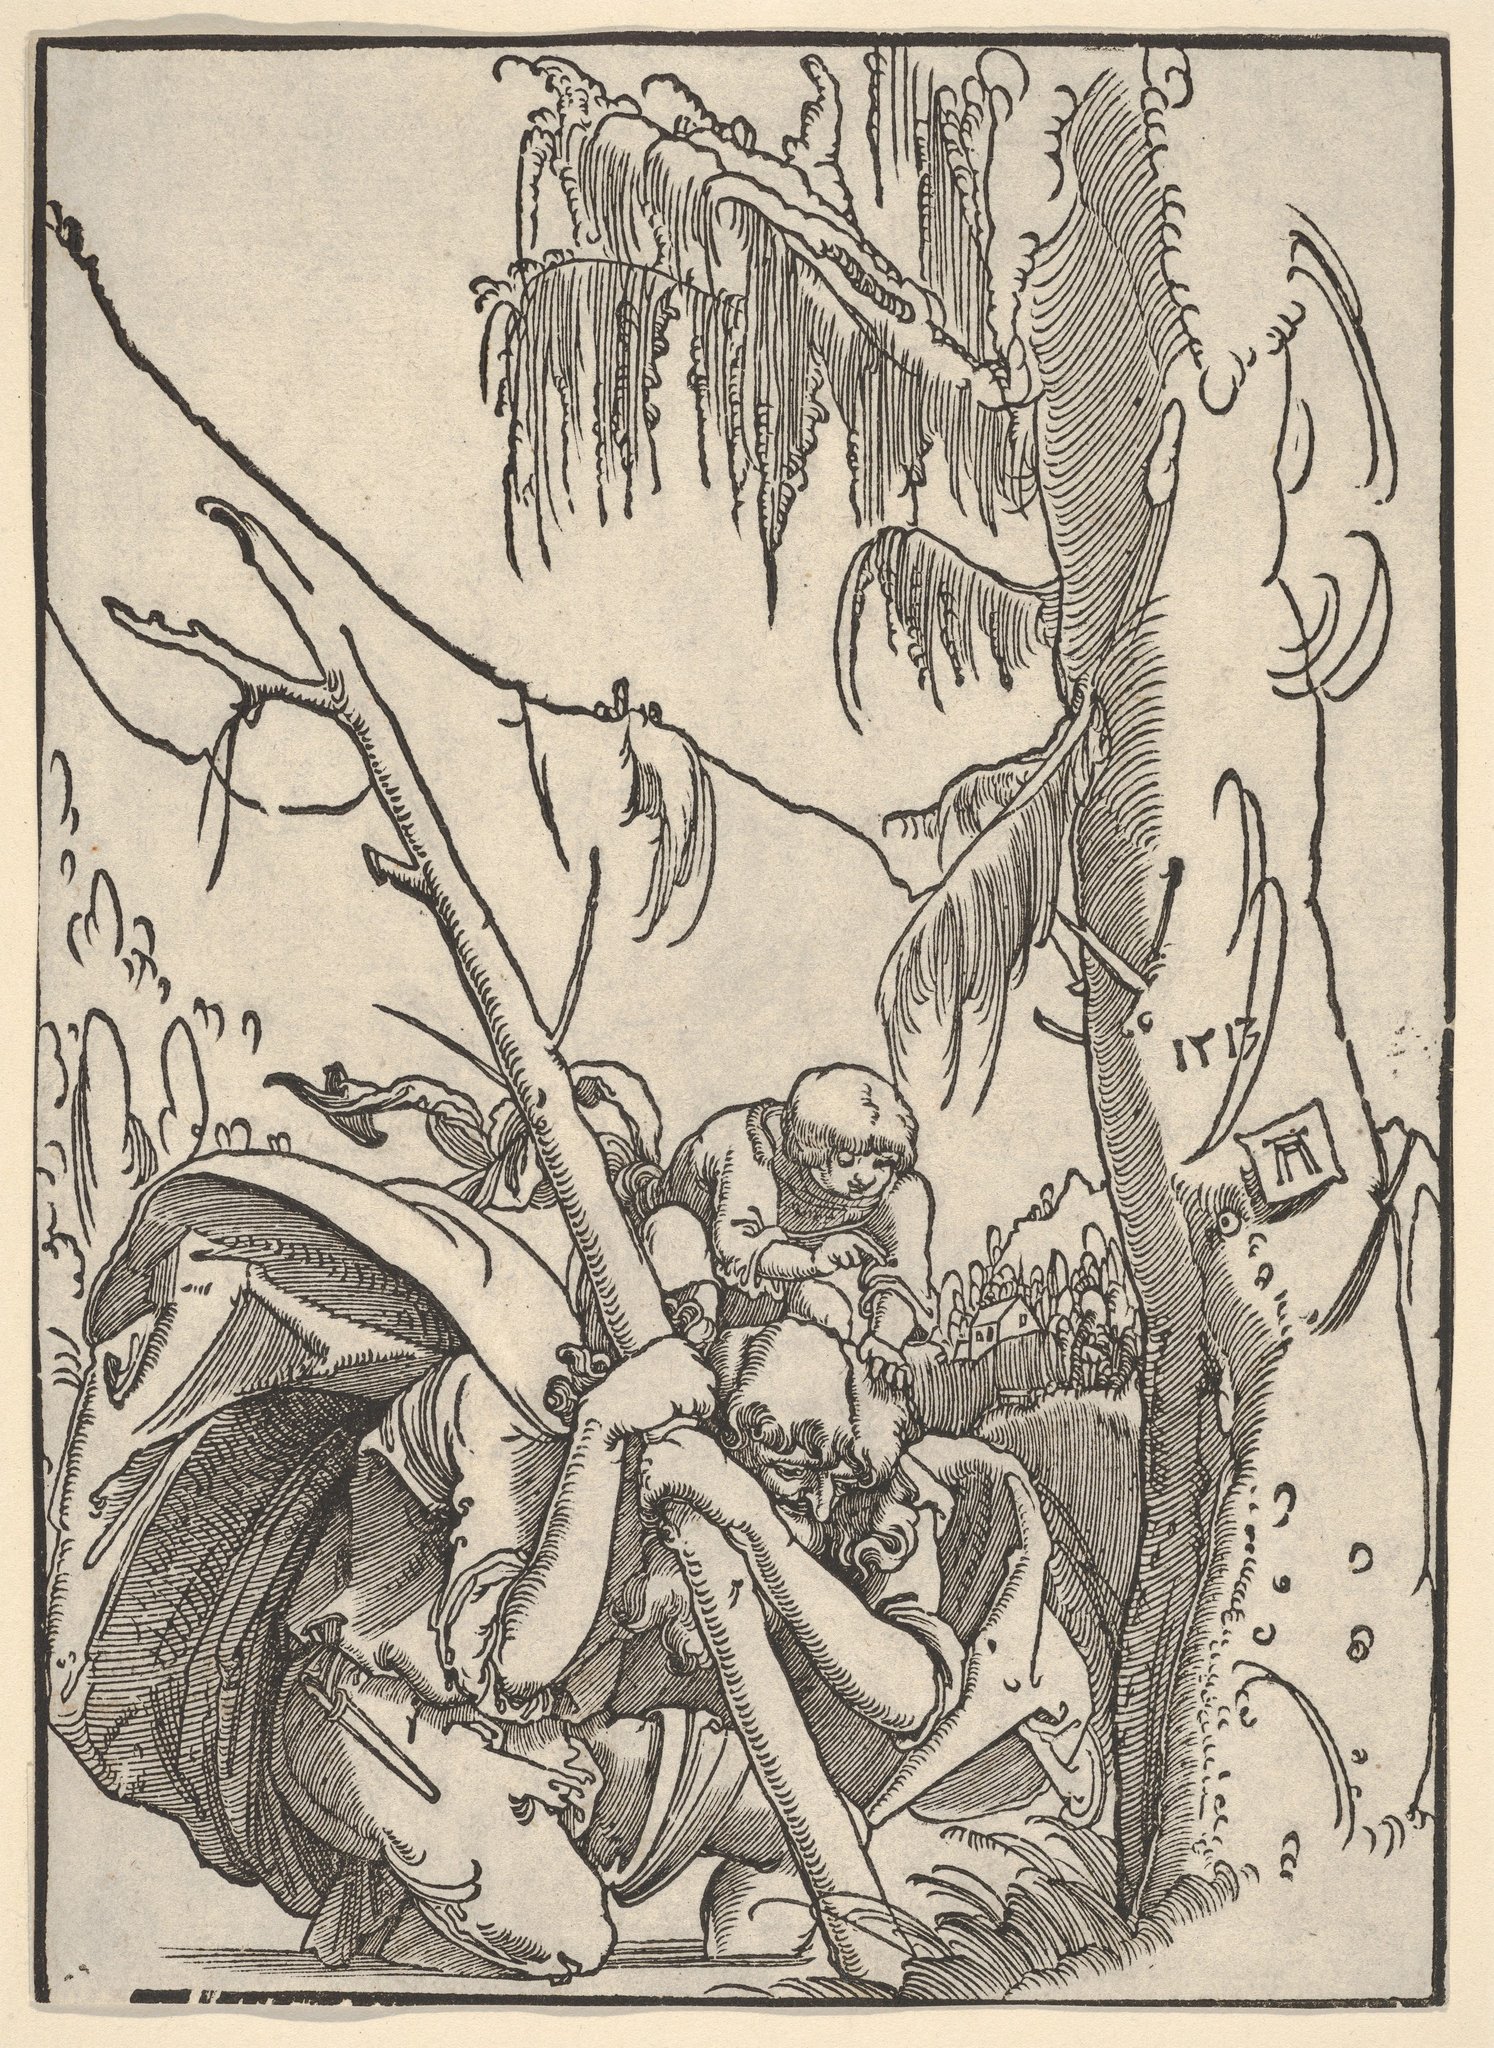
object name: print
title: Saint Christopher Carrying the Infant Christ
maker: albrecht altdorfer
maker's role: artist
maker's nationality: german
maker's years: 1480-1538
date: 1513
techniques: woodcut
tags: christ,saint christopher